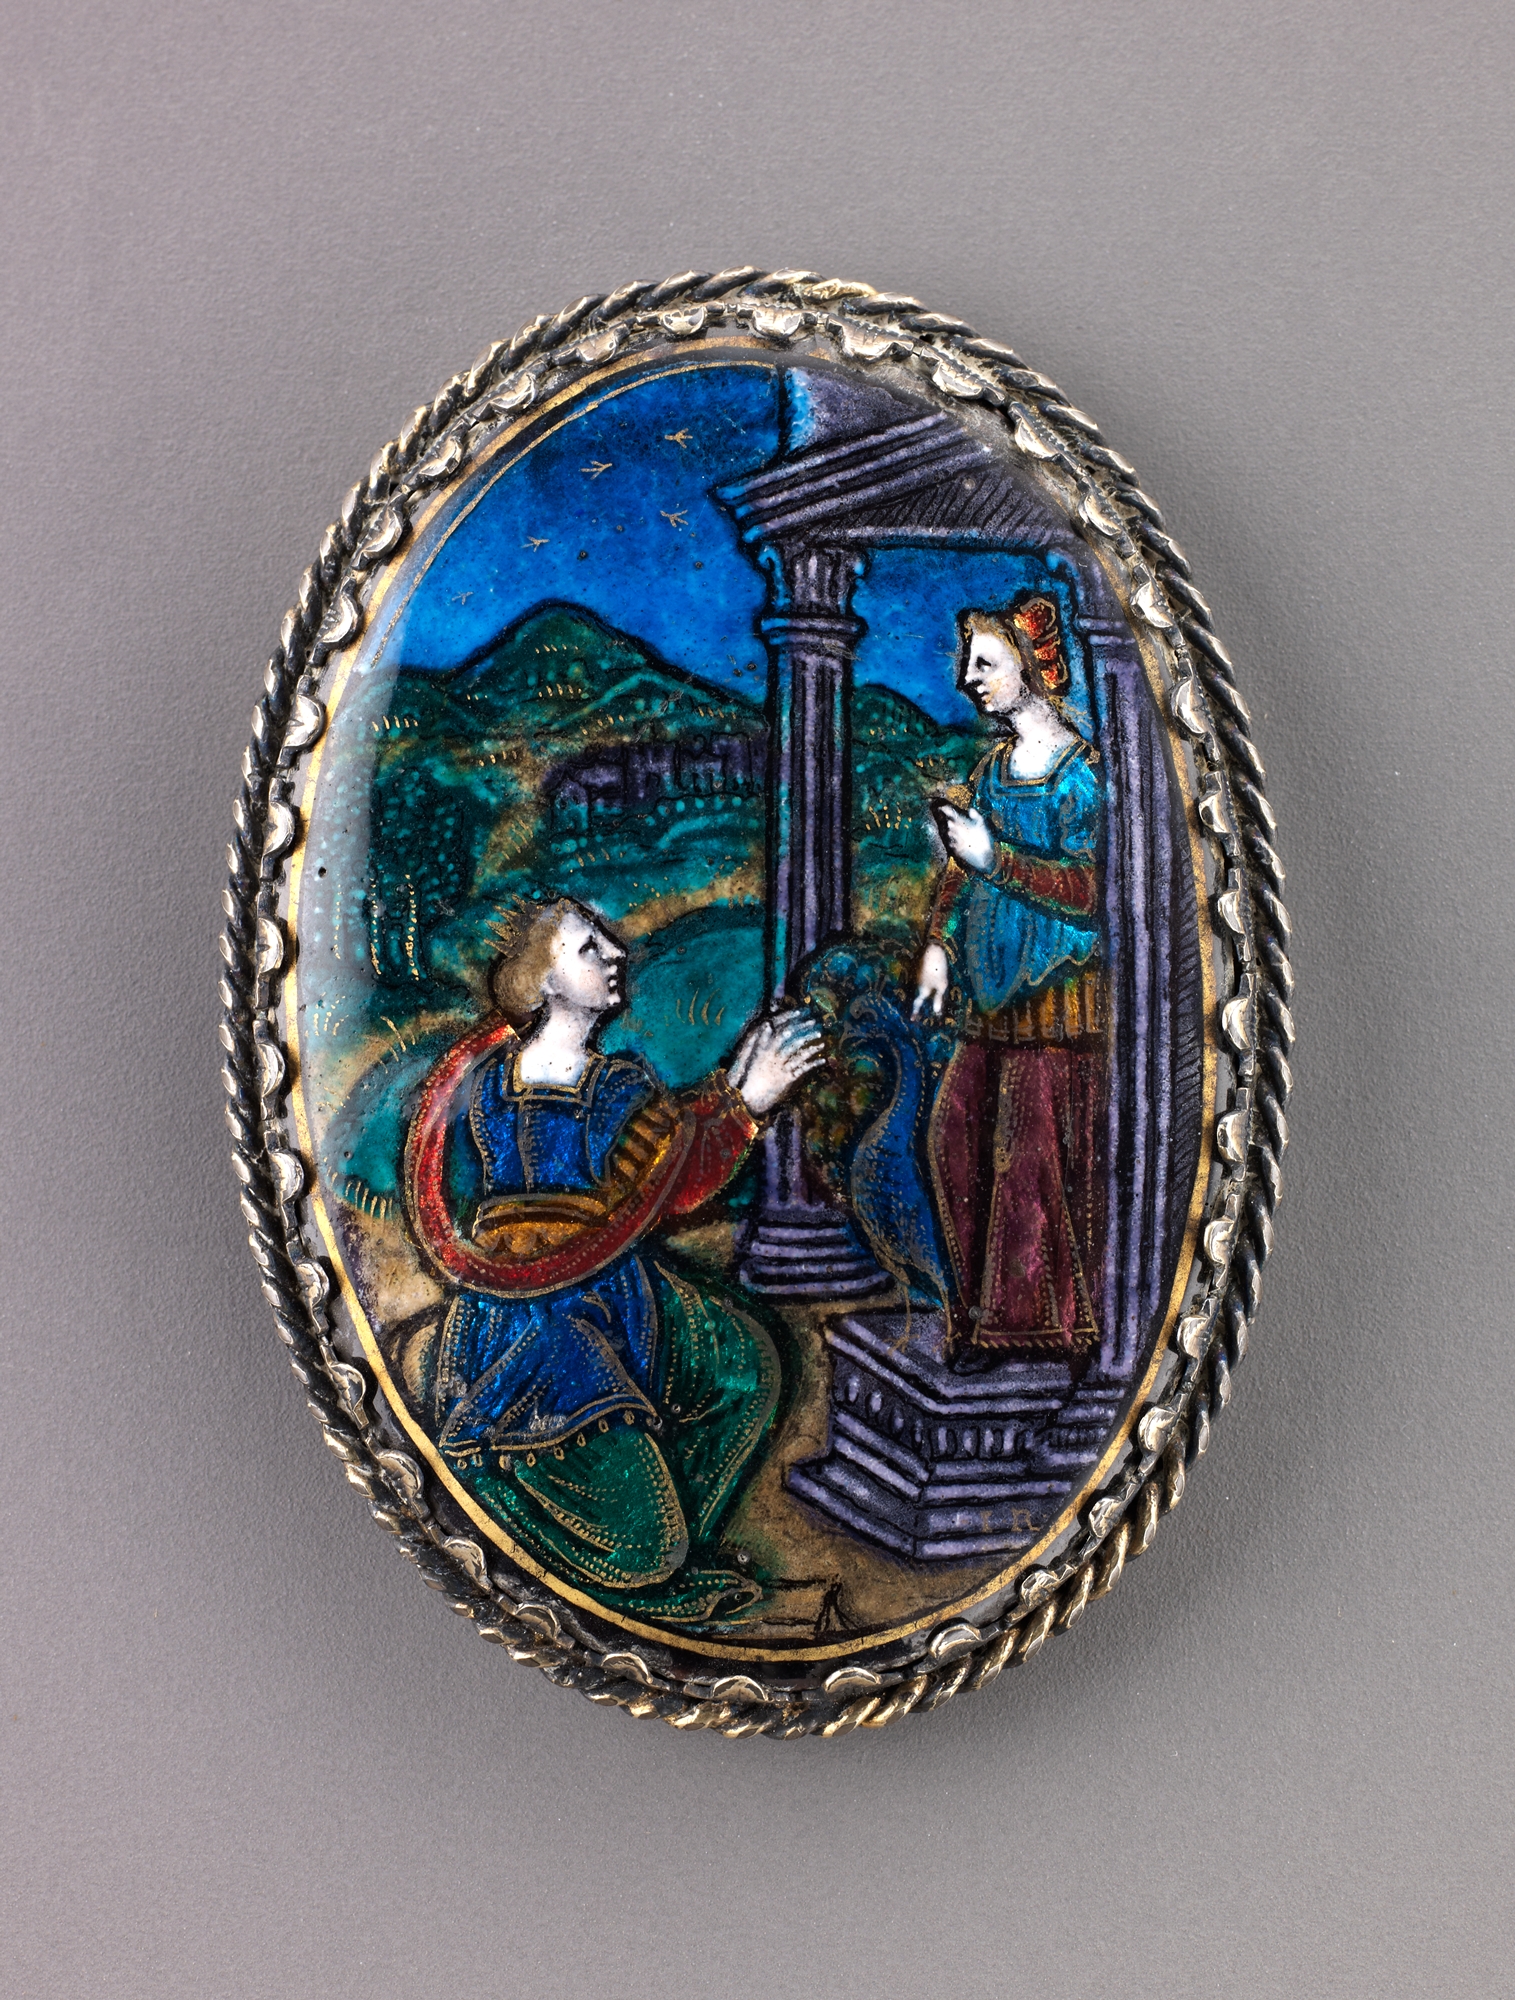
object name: watchcover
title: Watchcase cover: Alcyone Praying to Juno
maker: jean ii reymond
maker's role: artist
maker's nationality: french, limoges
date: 1615-1625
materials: brass, copper, enamel, gilt, silver gilt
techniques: painting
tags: women